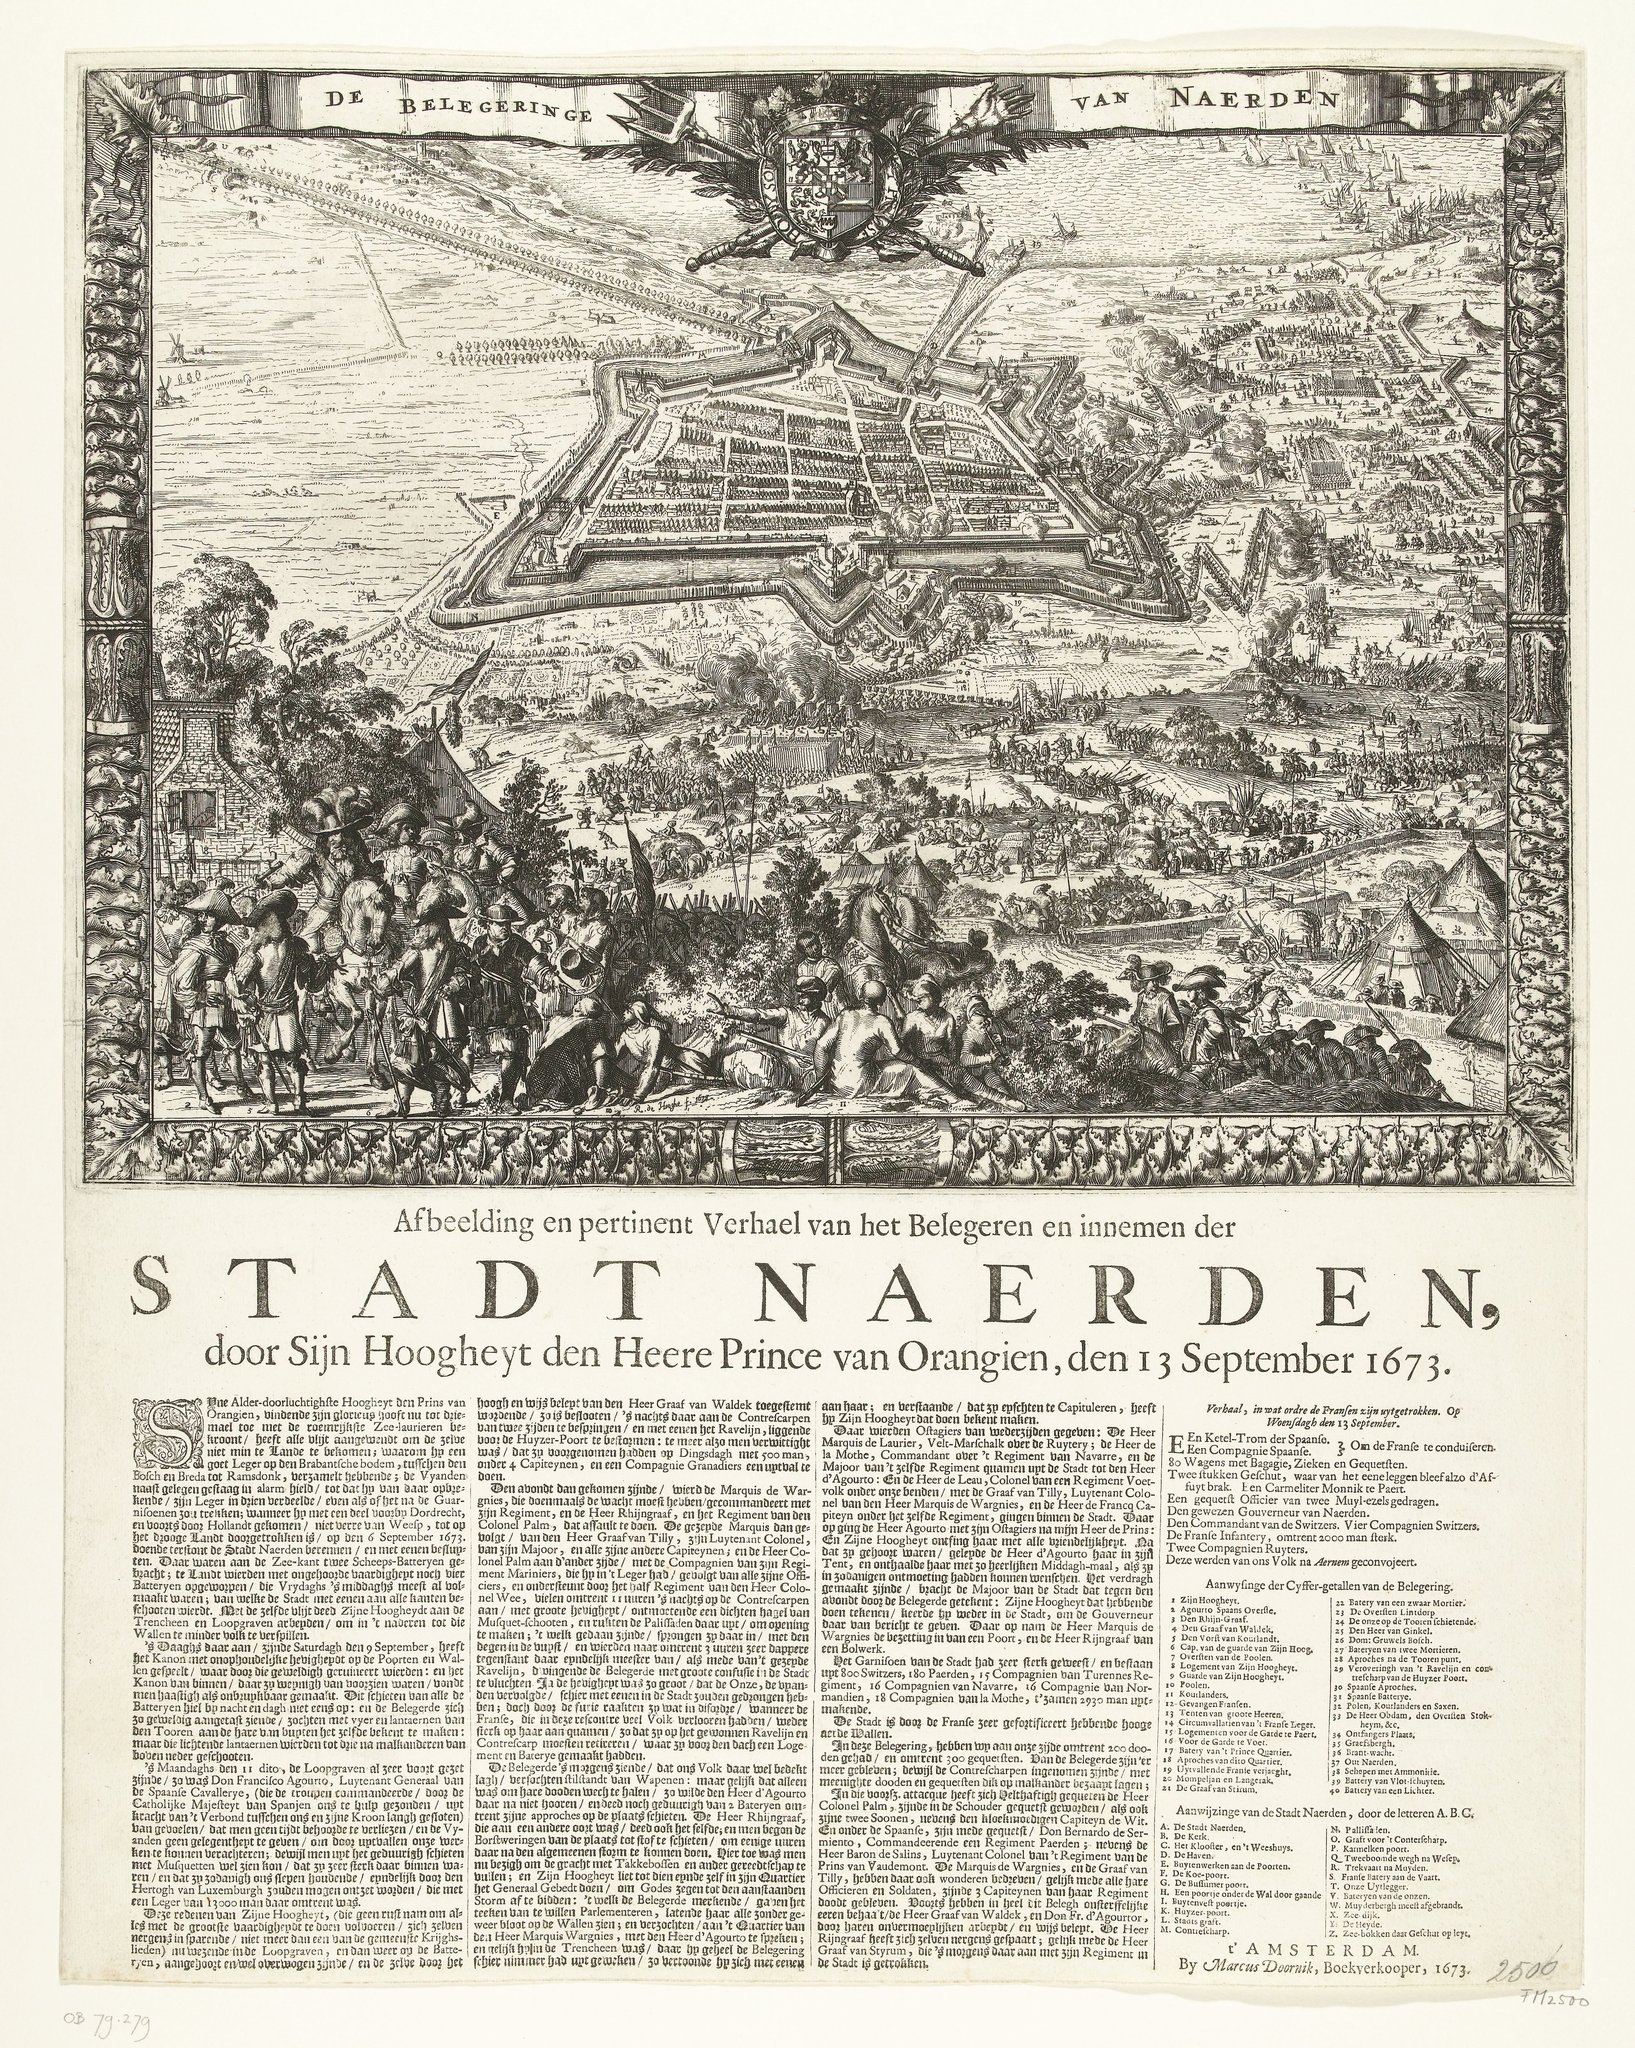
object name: print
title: Belegering en verovering van Naarden door de prins van Oranje, 1673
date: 1673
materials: paper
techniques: etching, letterpress printing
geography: amsterdam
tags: william iii (prince of orange and king of england, scotland, and ireland), siege, position war, capture of city (after the siege), armorial bearing, heraldry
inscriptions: date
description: Belegering en verovering van Naarden door de prins van Oranje, 12 september 1673. Gezicht op de belegering van de stad in vogelvluchtperspectief. Op de voorgrond de prins met zijn staf. Bovenaan het wapen van de prins. De voorstelling in een omlijsting van bladeren. Midden op de voorgrond een groepje buitenanders waaronder enkele zwarte mensen aangeduid in de legenda als Kourlanders (of Koutlanders). Onder de plaat een tekstblad met titel en 4 kolommen met een beschrijving van de gebeurtenissen en de legenda's 1-40 en A-Z.